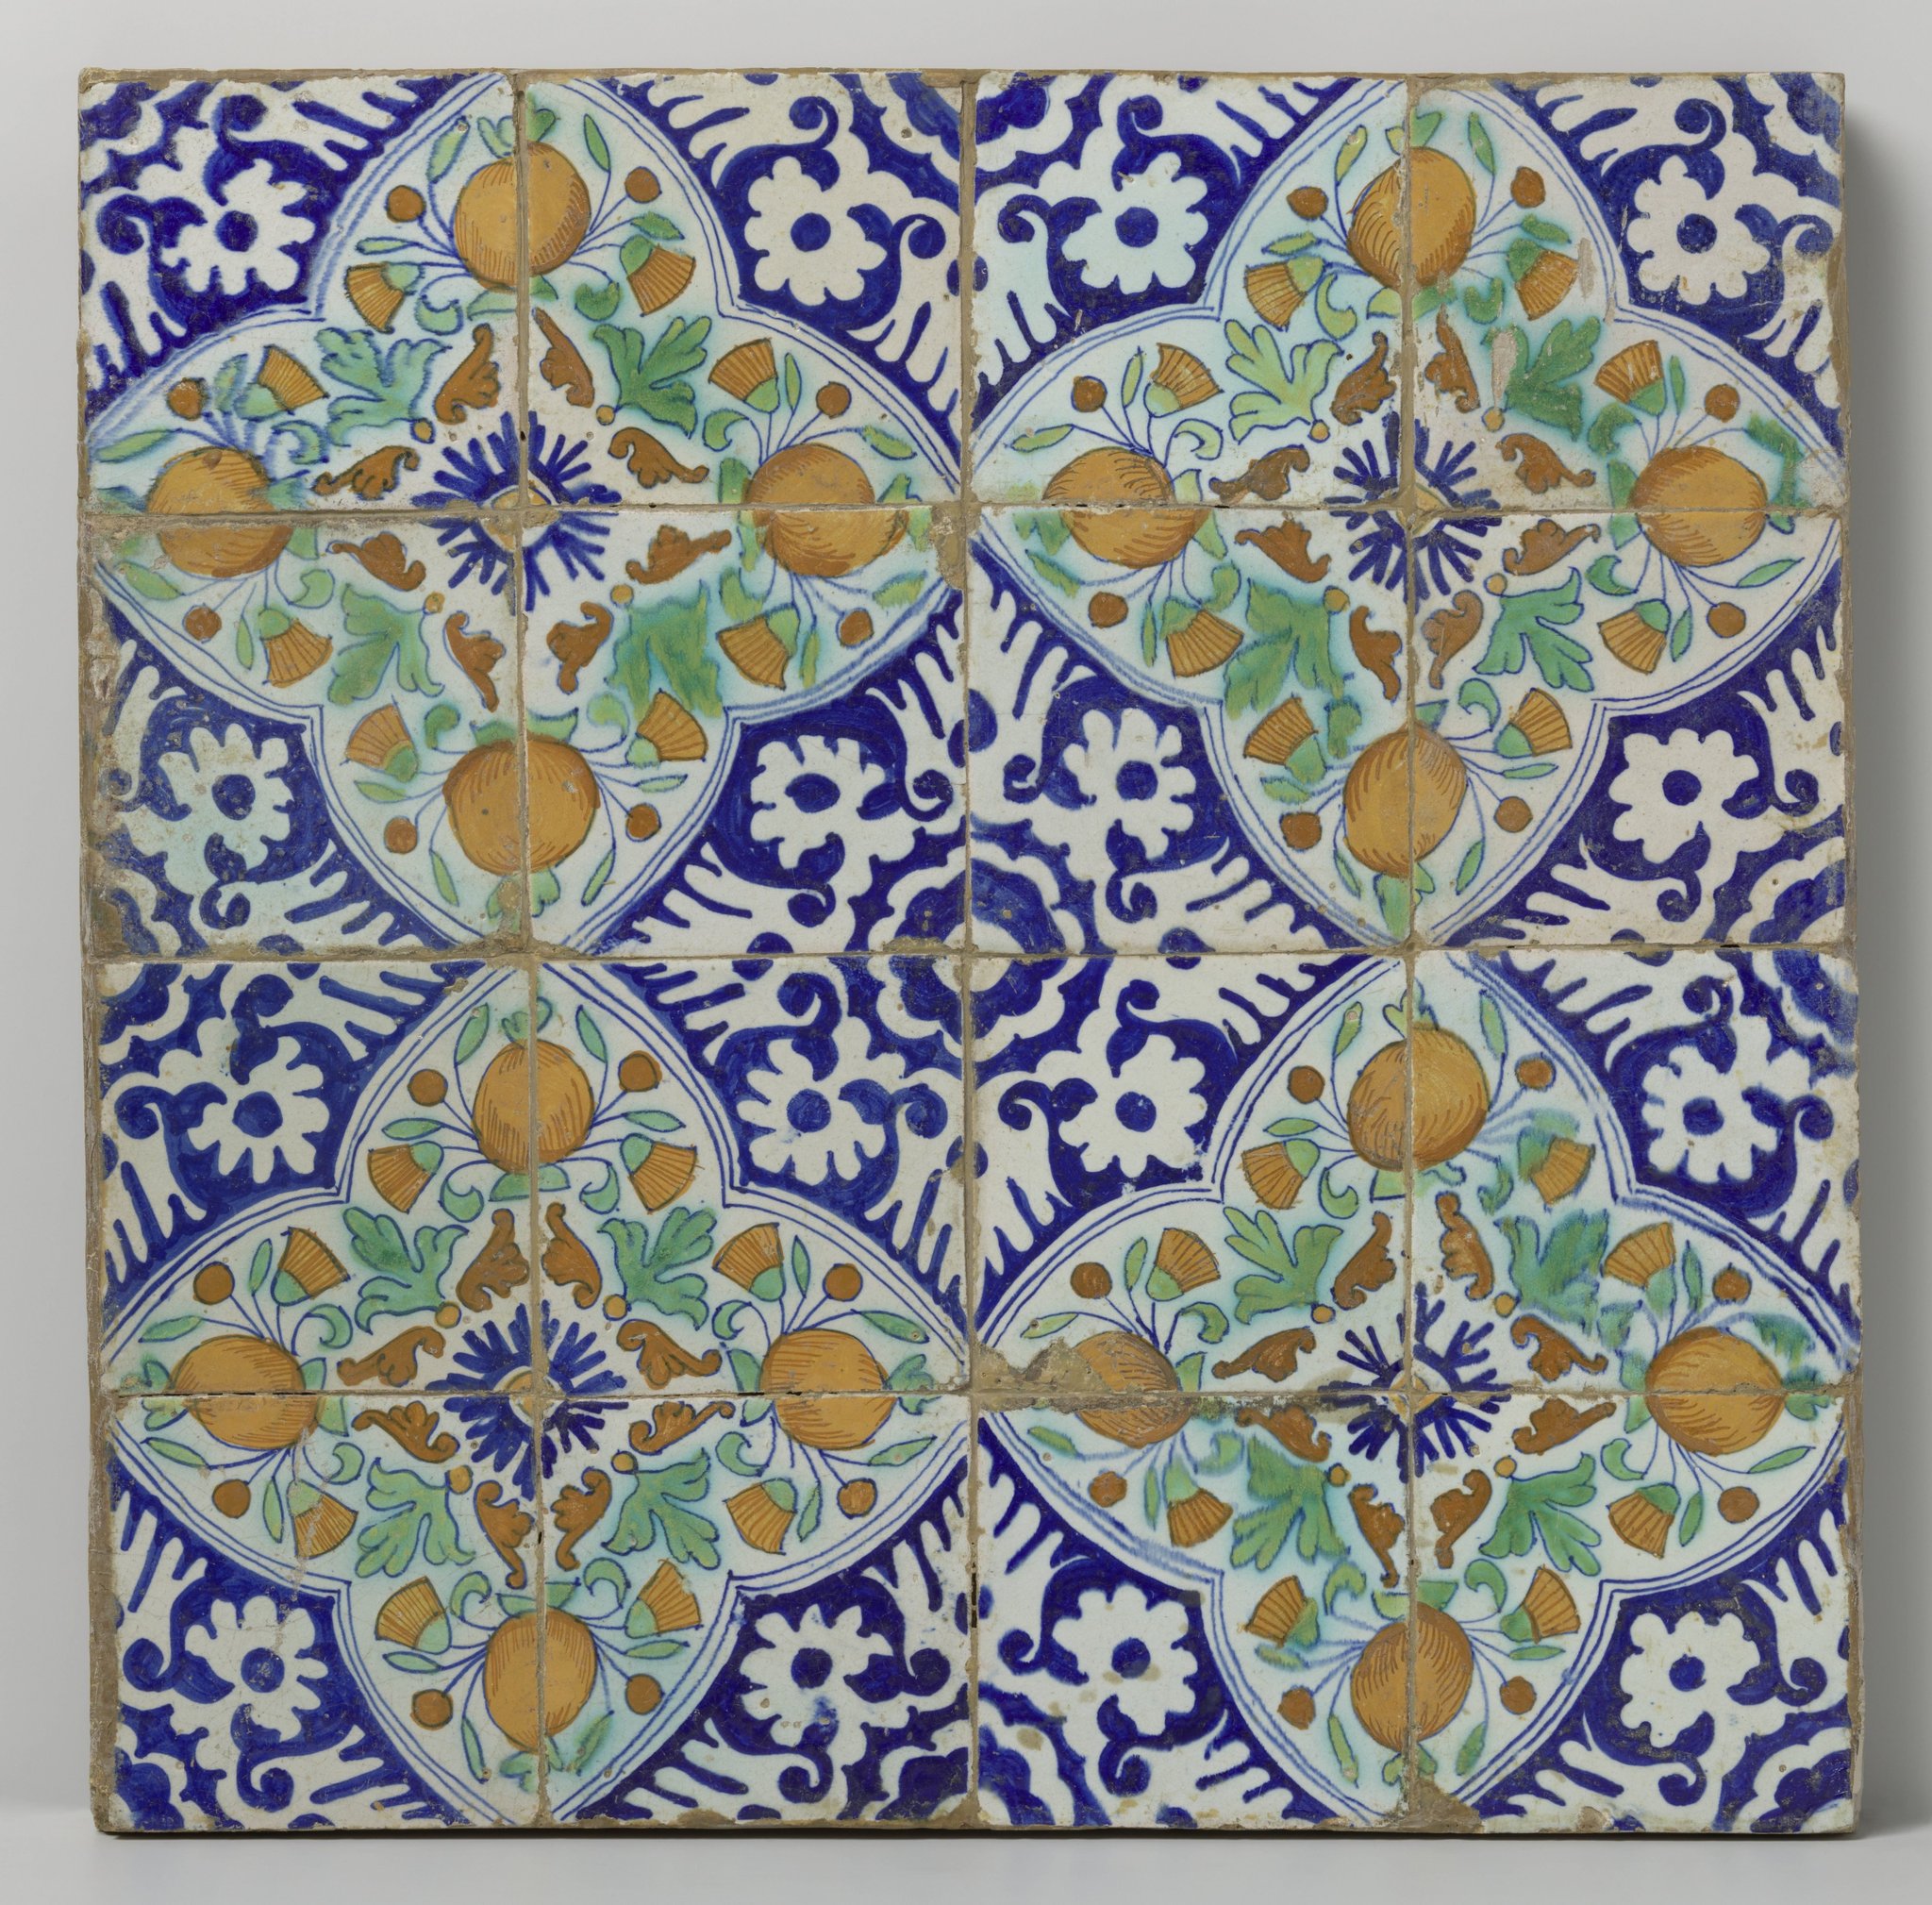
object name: vierpastegel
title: Veld van zestien tegels met granaatappels en goudsbloemen in een vierpas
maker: Anonymous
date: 1580-1620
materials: earthenware, glaze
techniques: maiolica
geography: netherlands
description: Veld van zestien tegels (4 x 4) met veelkleurig (blauw, oranje, groen en geel) geschilderde granaatappels en goudsbloemen binnen een vierpas, gevormd uit vier tegels. De vierpassen zijn omgeven door ornament in vultechniek.